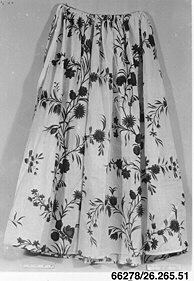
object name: apron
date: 1785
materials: cotton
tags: flowers